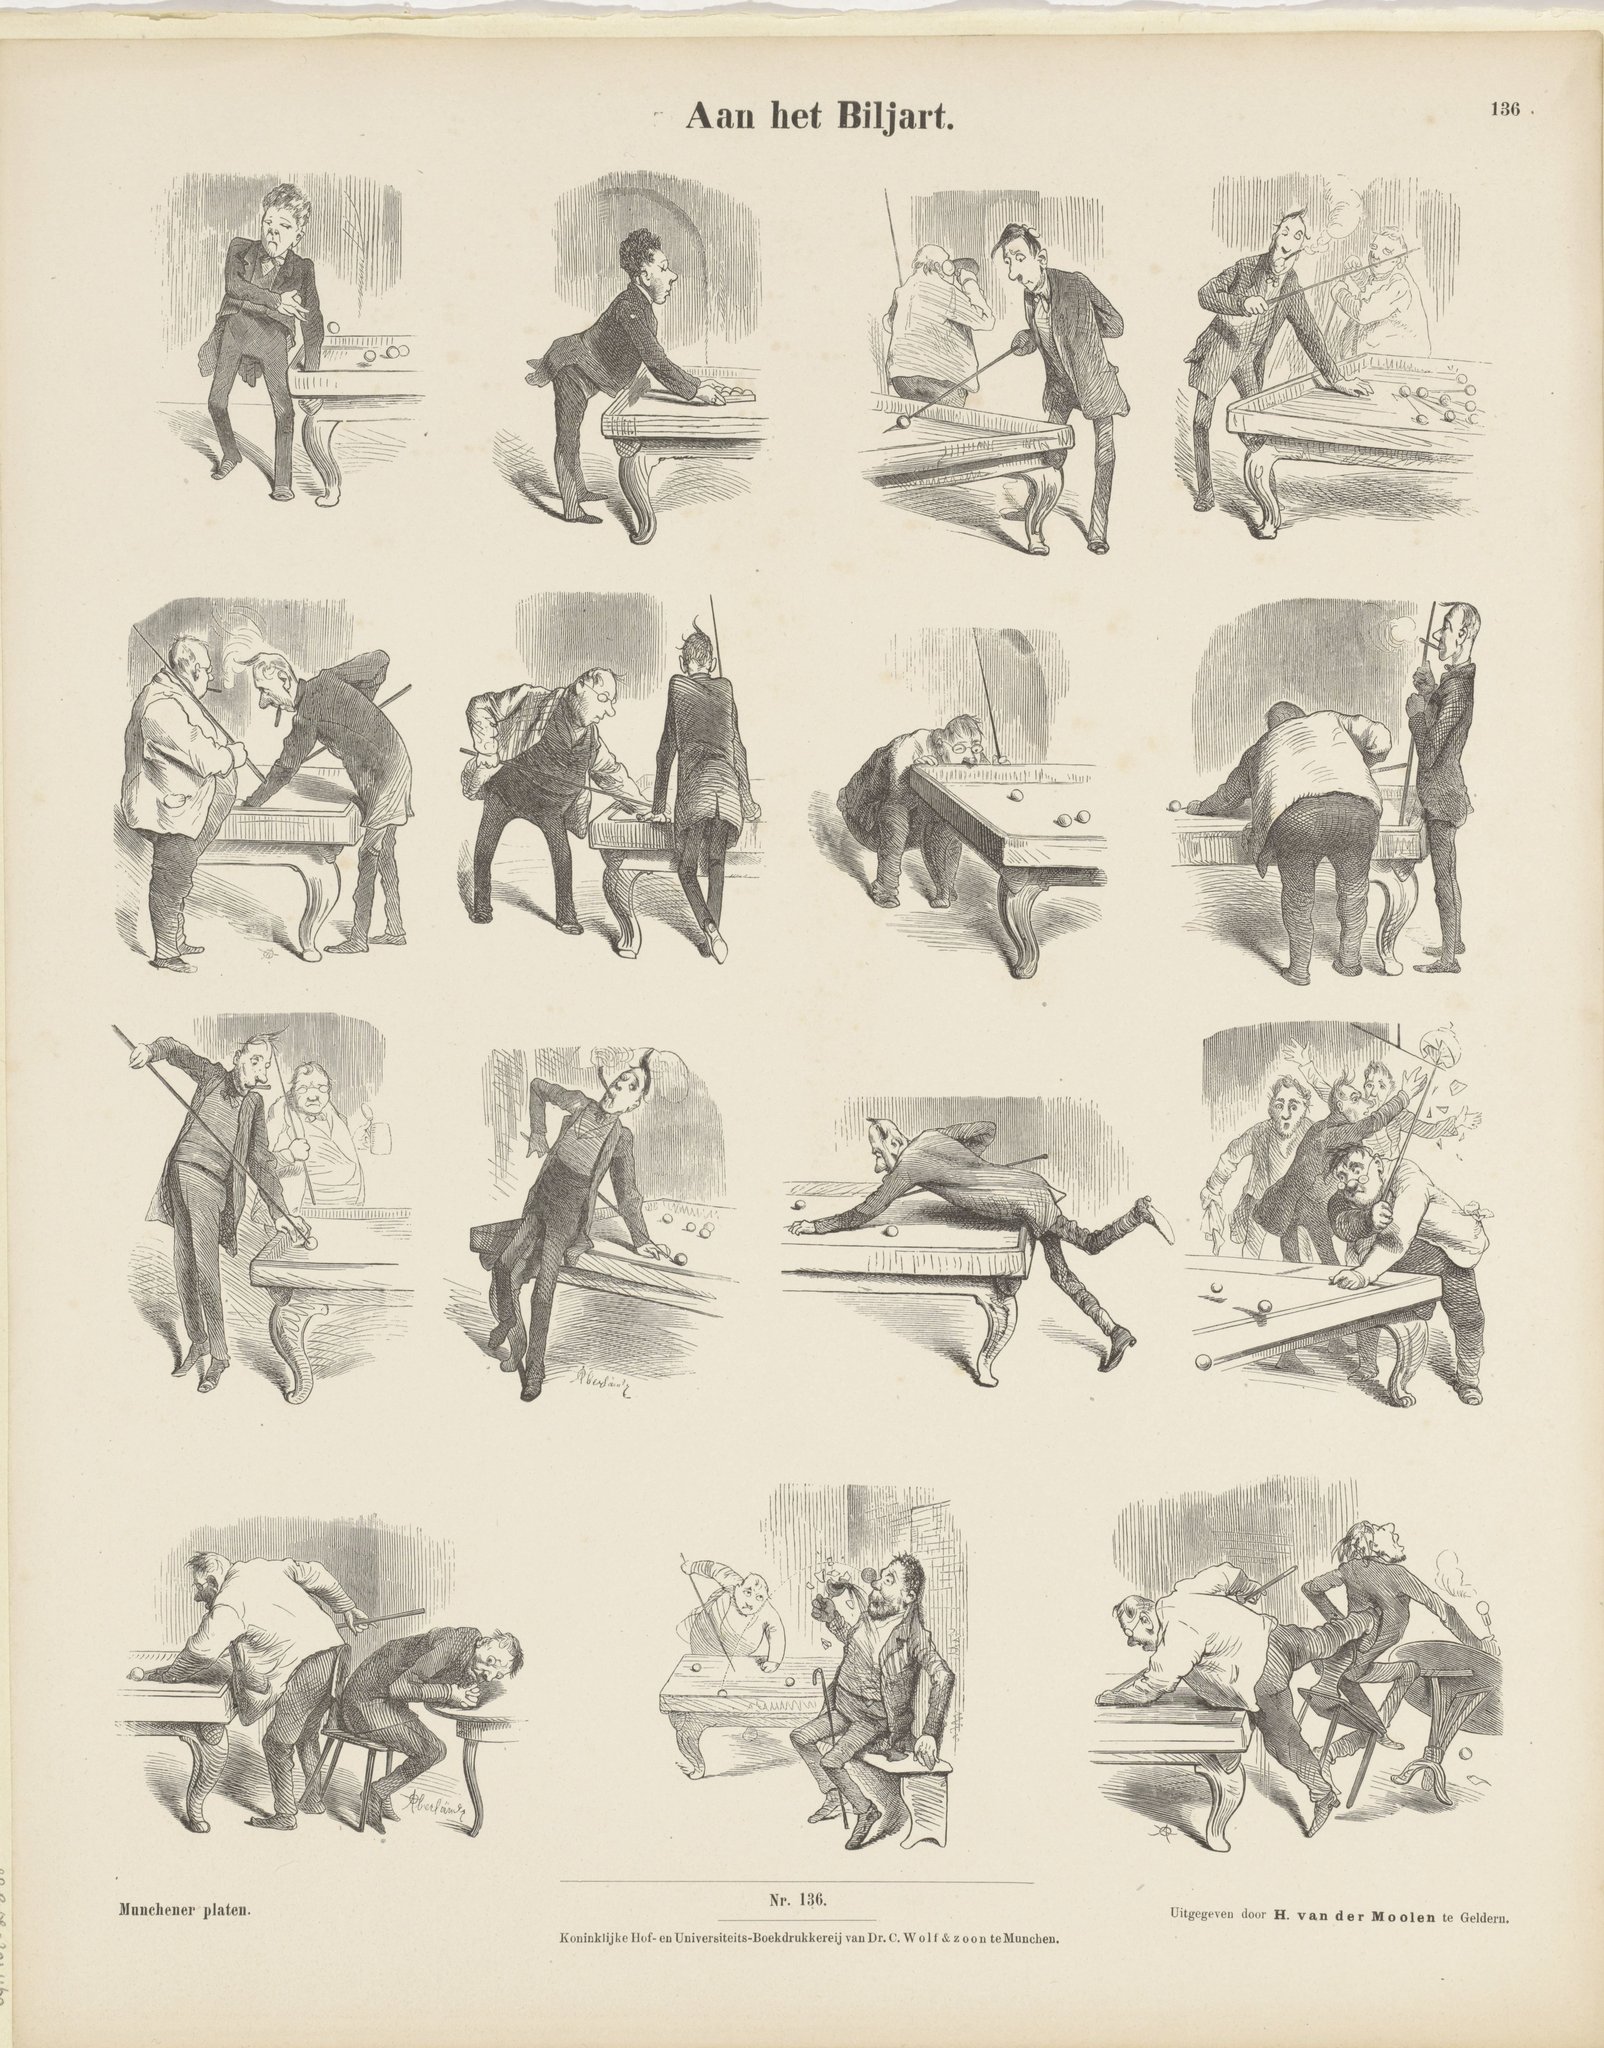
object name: print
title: Munchener platen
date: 1843-1920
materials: paper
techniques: letterpress printing, engraving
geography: germany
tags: billiards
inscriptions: collector's mark: Lugt 2760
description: Nederlandse editie van een prent uit de reeks "Munchener platen" uitgegeven door K. Braun & Fr. Schneider te München met het adres van wederverkoper Hermann van der Moolen.